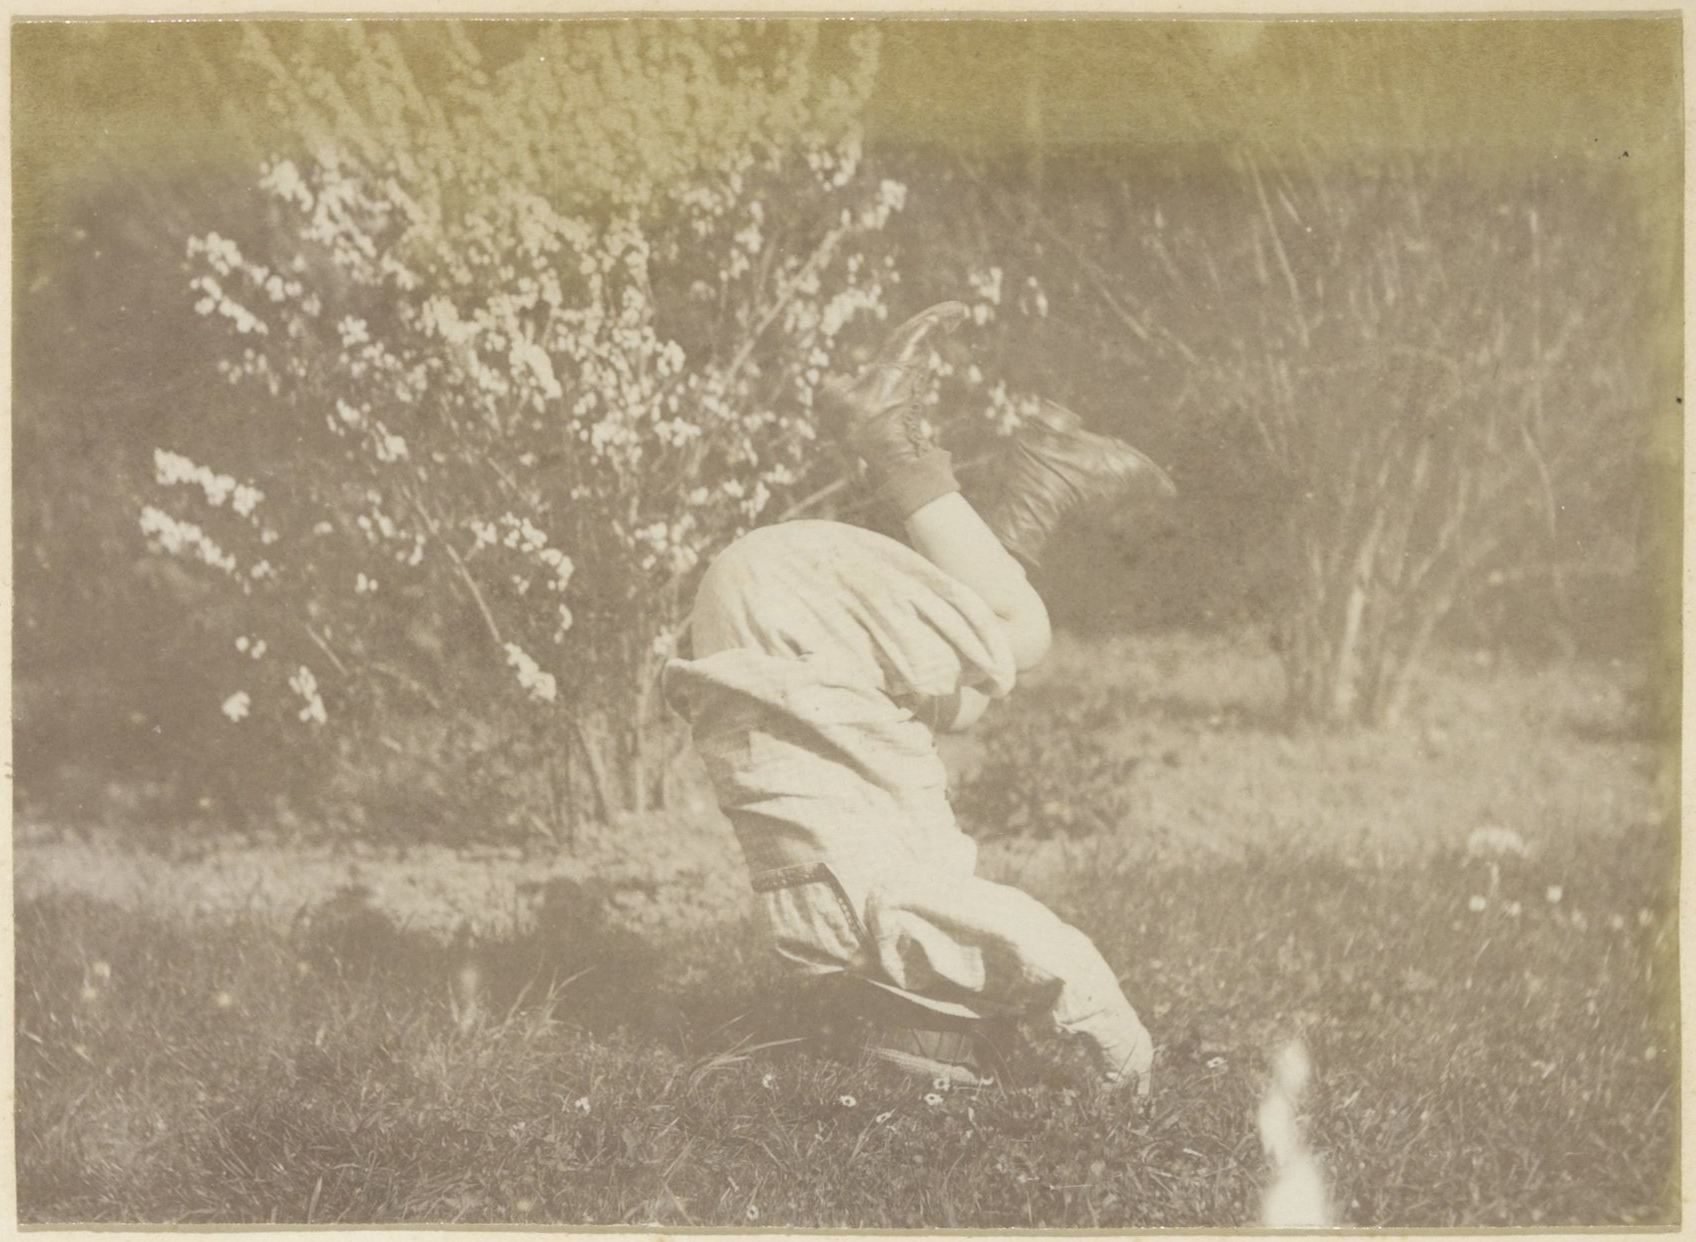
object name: photograph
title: Kind doet kopstand op grasveld in Frankrijk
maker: Anonymous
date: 1900-1910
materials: paper, photographic support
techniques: albumen print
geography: france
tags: gymnastic exercises on the ground, france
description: Onderdeel van Fotoalbum van een Franse amateurfotograaf met opnames van een familie, distilleerderij Delizy & Doistau Fils, het leger en bezienswaardigheden in Frankrijk.